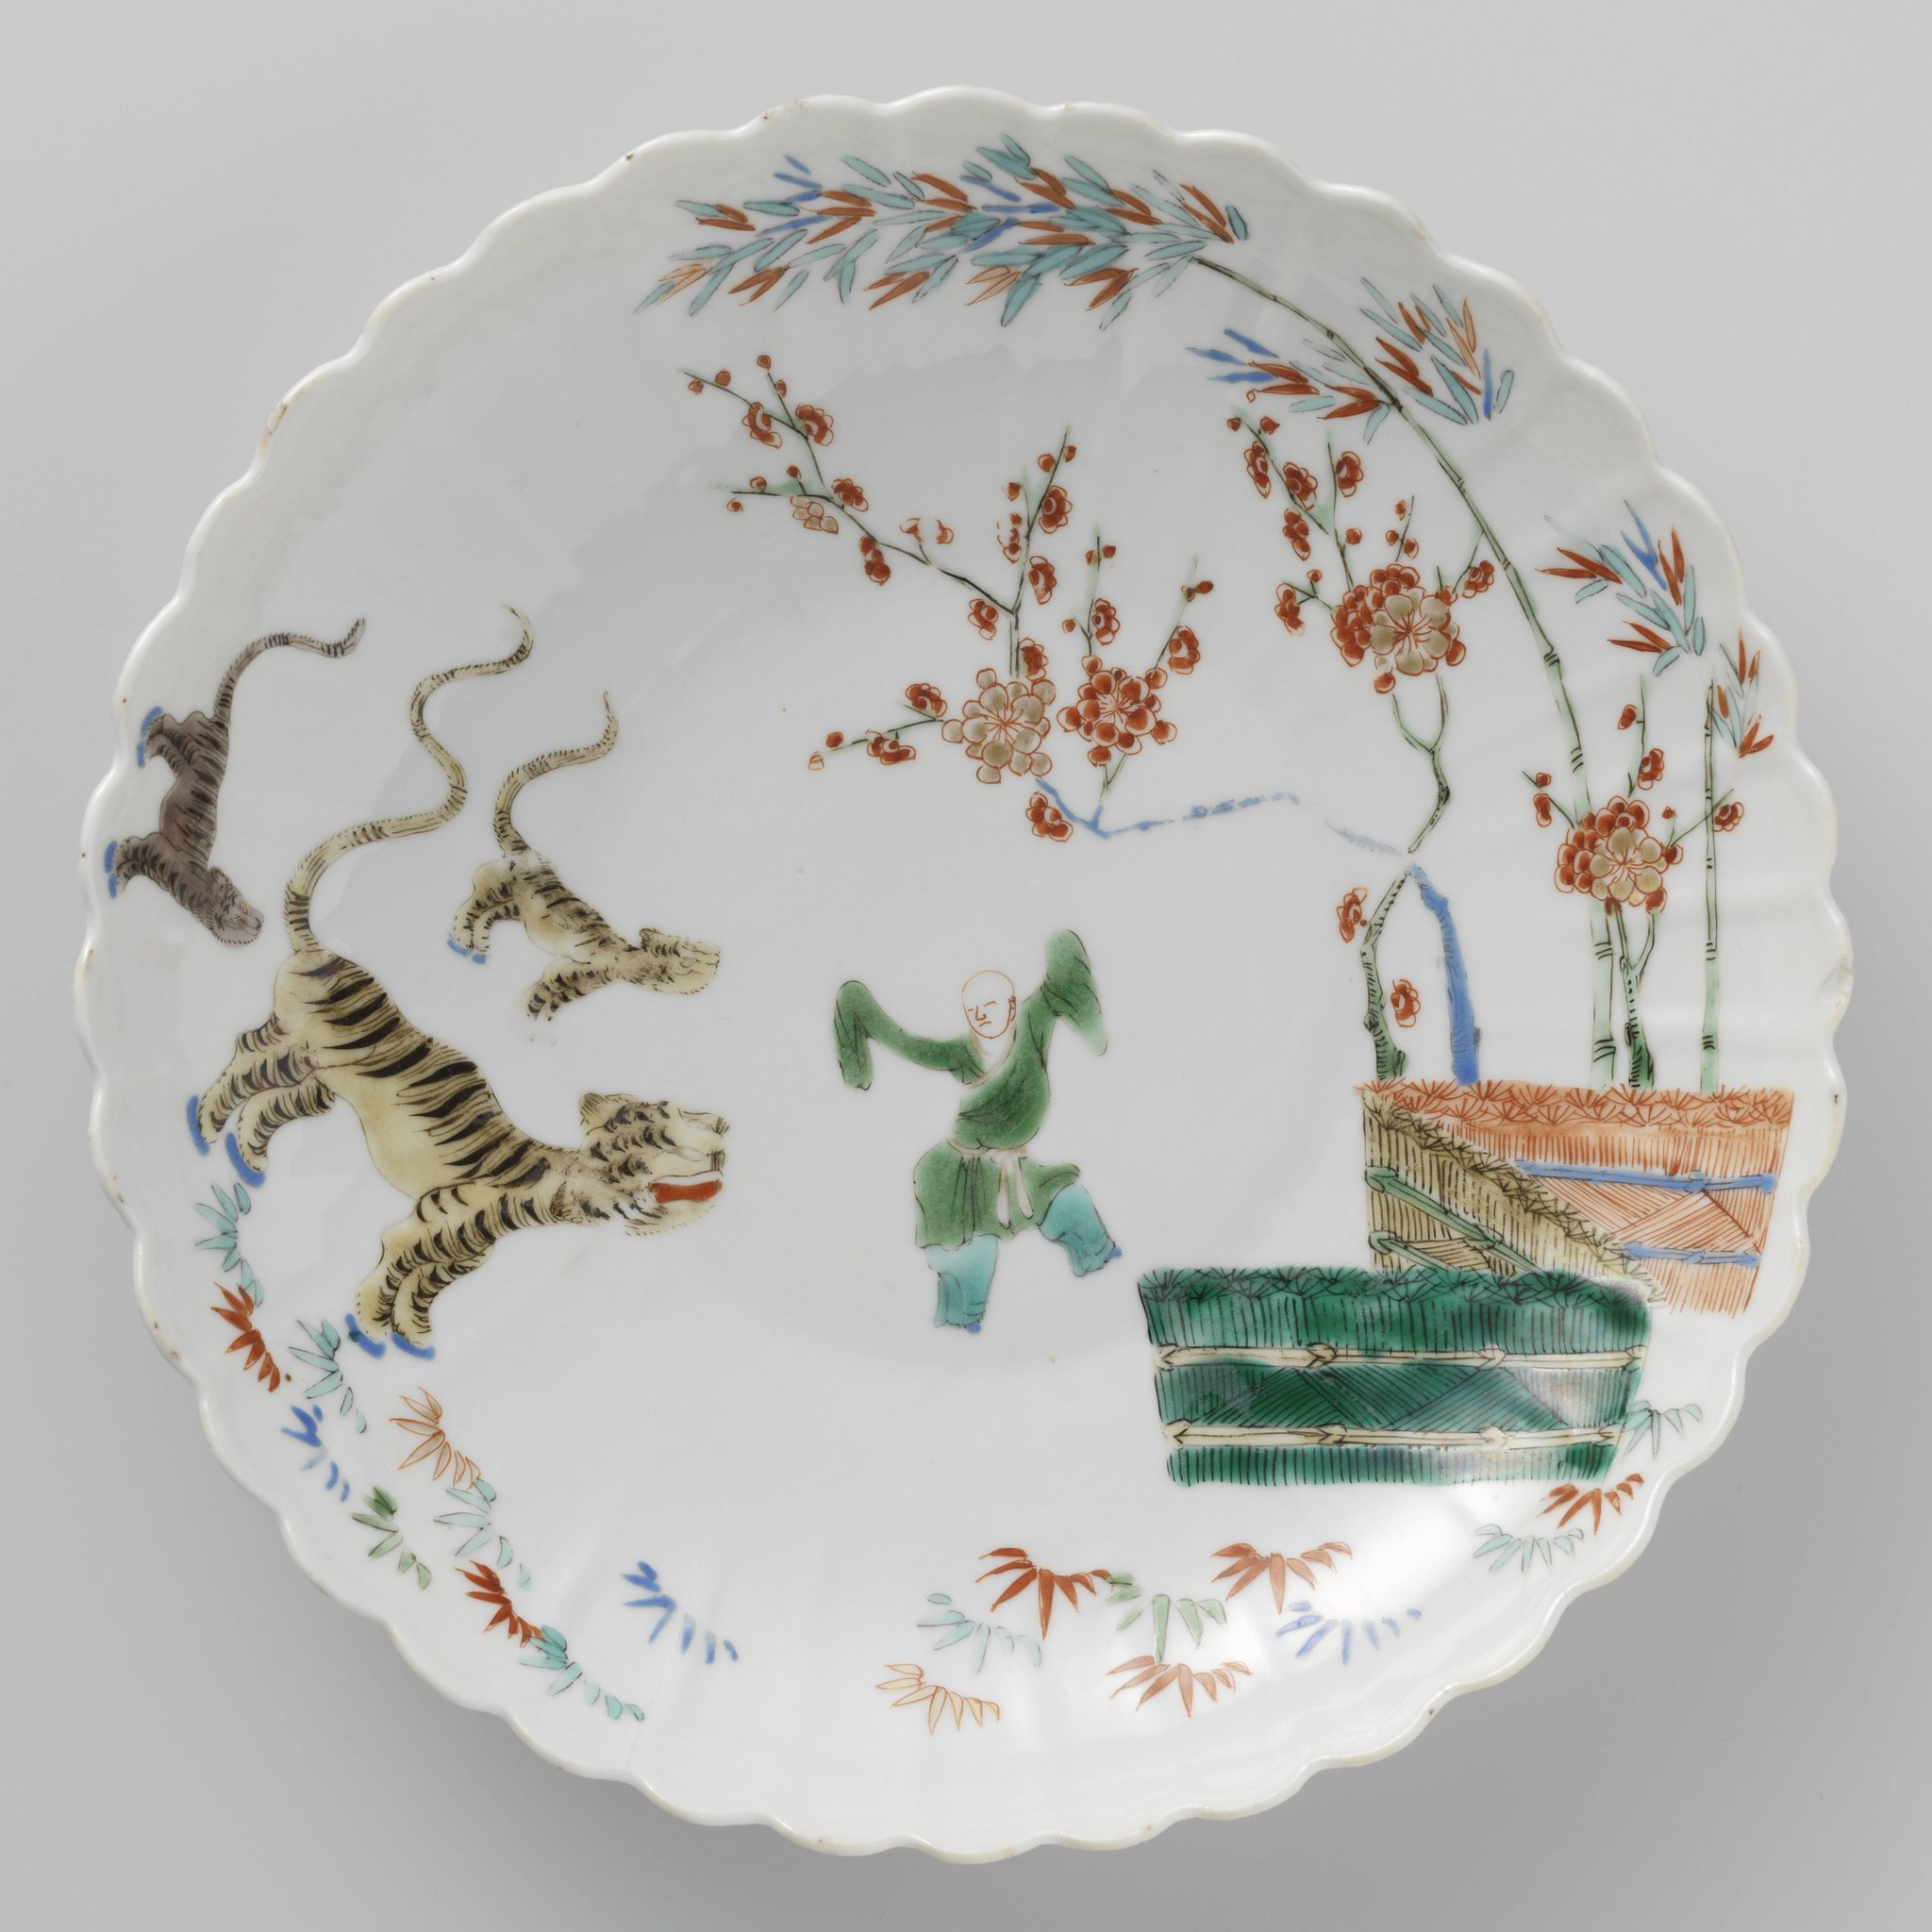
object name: dish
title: Saucer-dish with bamboo, prunus, tiger and a Chinese boy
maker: Anonymous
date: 1700-1724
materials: glaze, gold, paint, porcelain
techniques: firing, gilding, turning, vitrification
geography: china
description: Schaal van porselein met een geribde wand en gelobde rand, beschilderd op het glazuur in blauw, rood, groen, geel, zwart en goud. Op de voorzijde een dansende Chinese jongen tussen drie tijgers aan de ene kant en bamboe en prunustak achter bijeengebonden heggen aan de andere kant. Famille verte in de Japanse Kakiemon-stijl. NB: gebroken in doos.